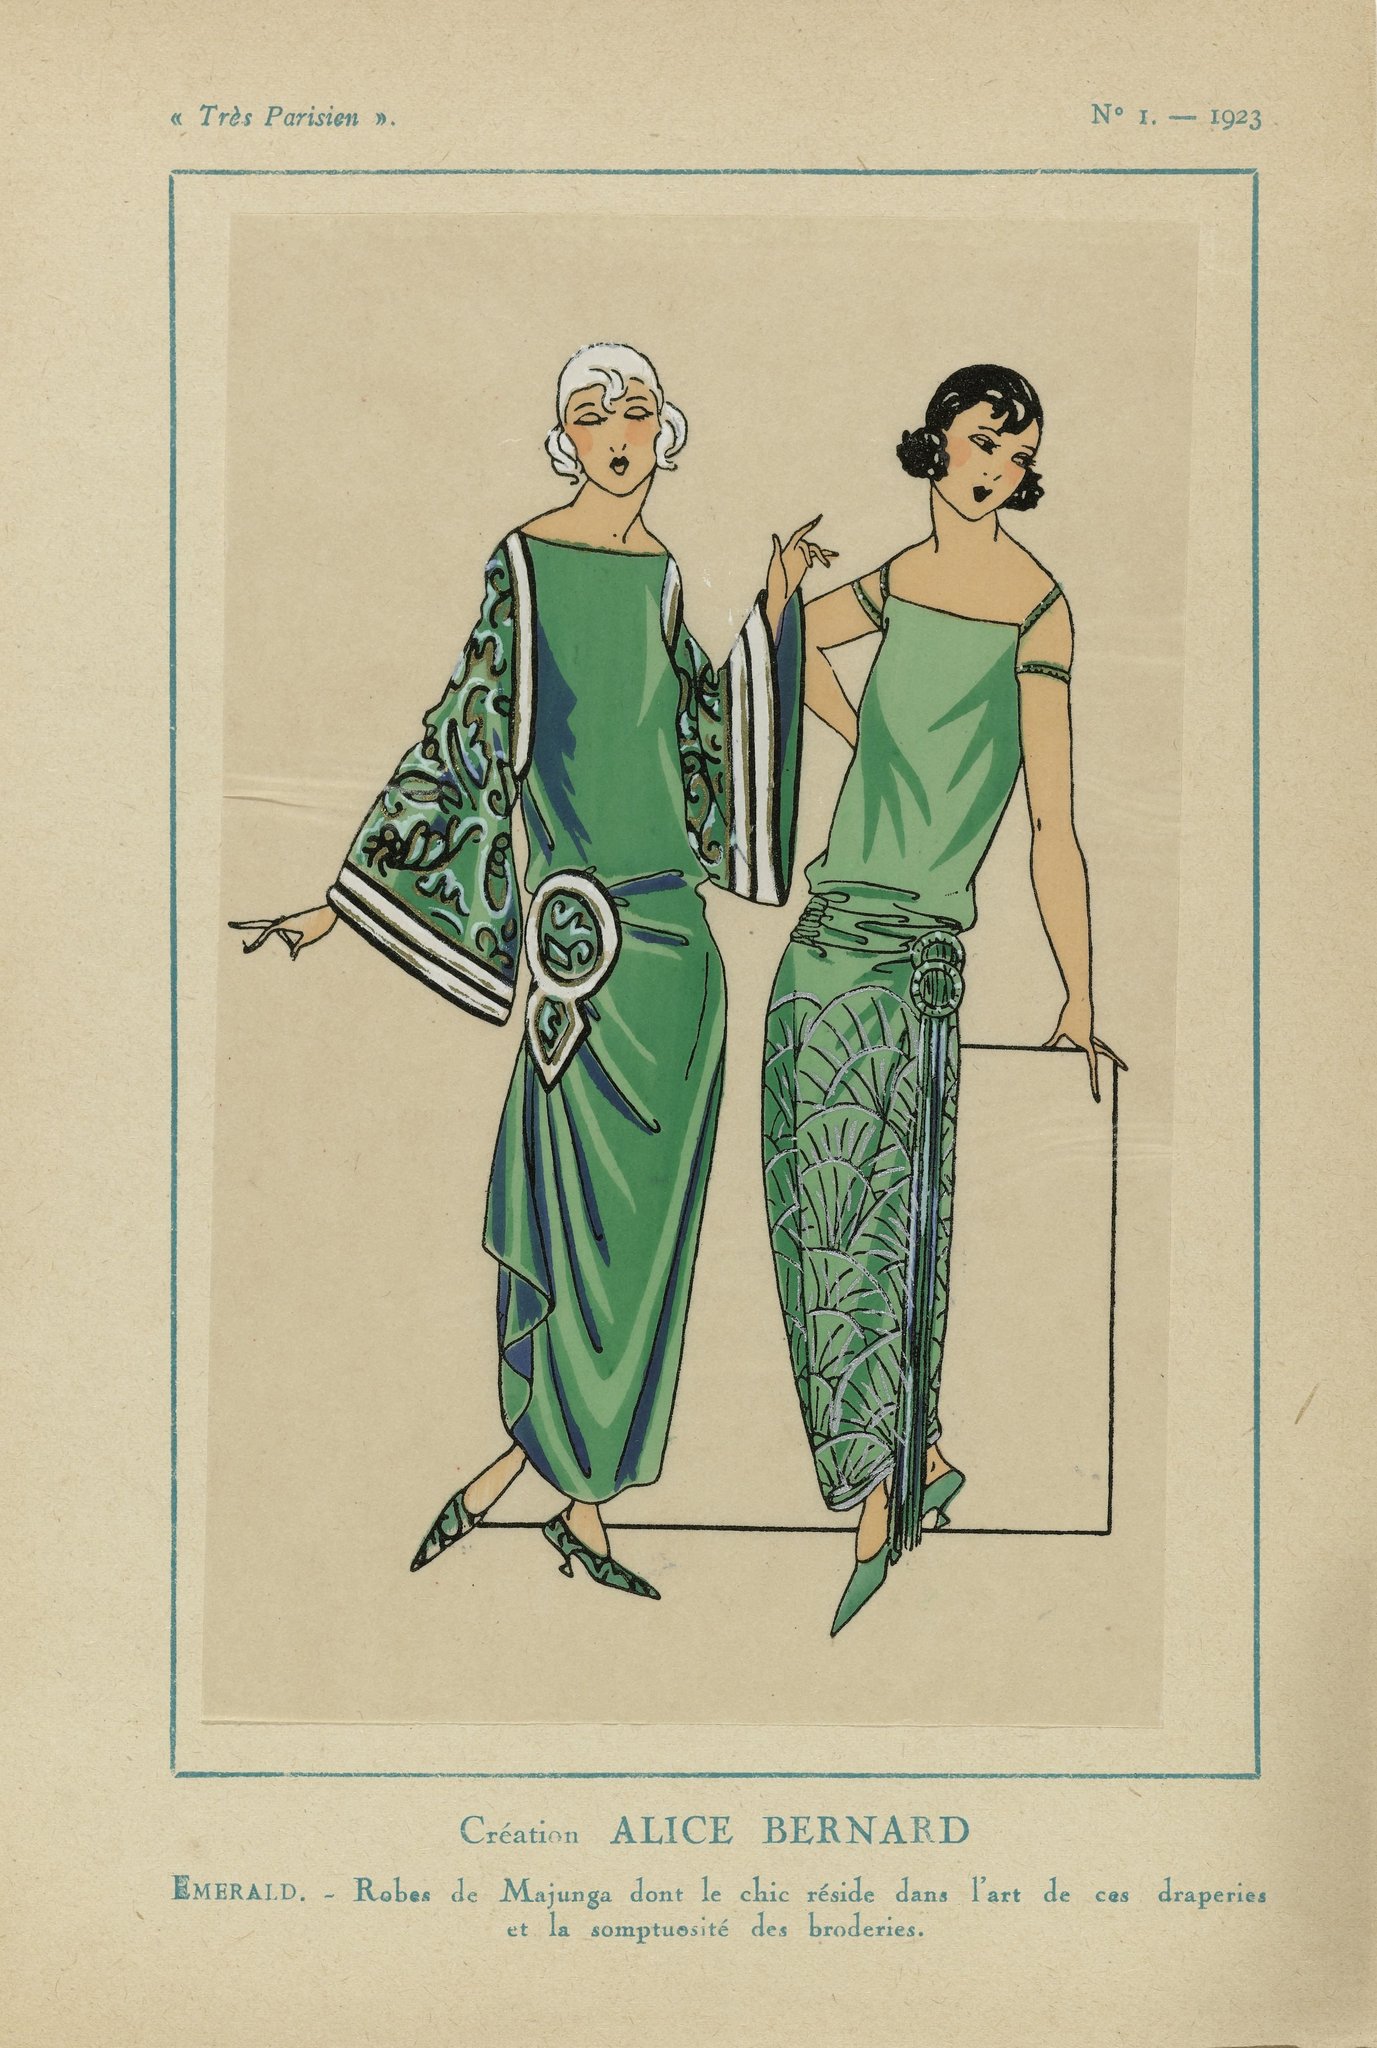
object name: fashion print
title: Très Parisien, 1923, No. 1: Creation ALICE BERNARD...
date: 1923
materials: paper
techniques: hand coloring, letterpress printing, lithography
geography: paris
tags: embroidery (ornamentation) (+ women's clothes), fashion plates, dress, gown (+ women's clothes)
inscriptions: title: ‘Très Parisien / No 1. - 1923’, caption: ‘Création ALICE BERNARD / EMERALD. - Robes de Majunga dont le chic réside dans l'art de ces draperies et la somptuosité des broderies.’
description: Twee smaragdgroene japonnen van Alice Bernard, met borduursels. Prent uit het modetijdschrift Très Parisien (1920-1936).